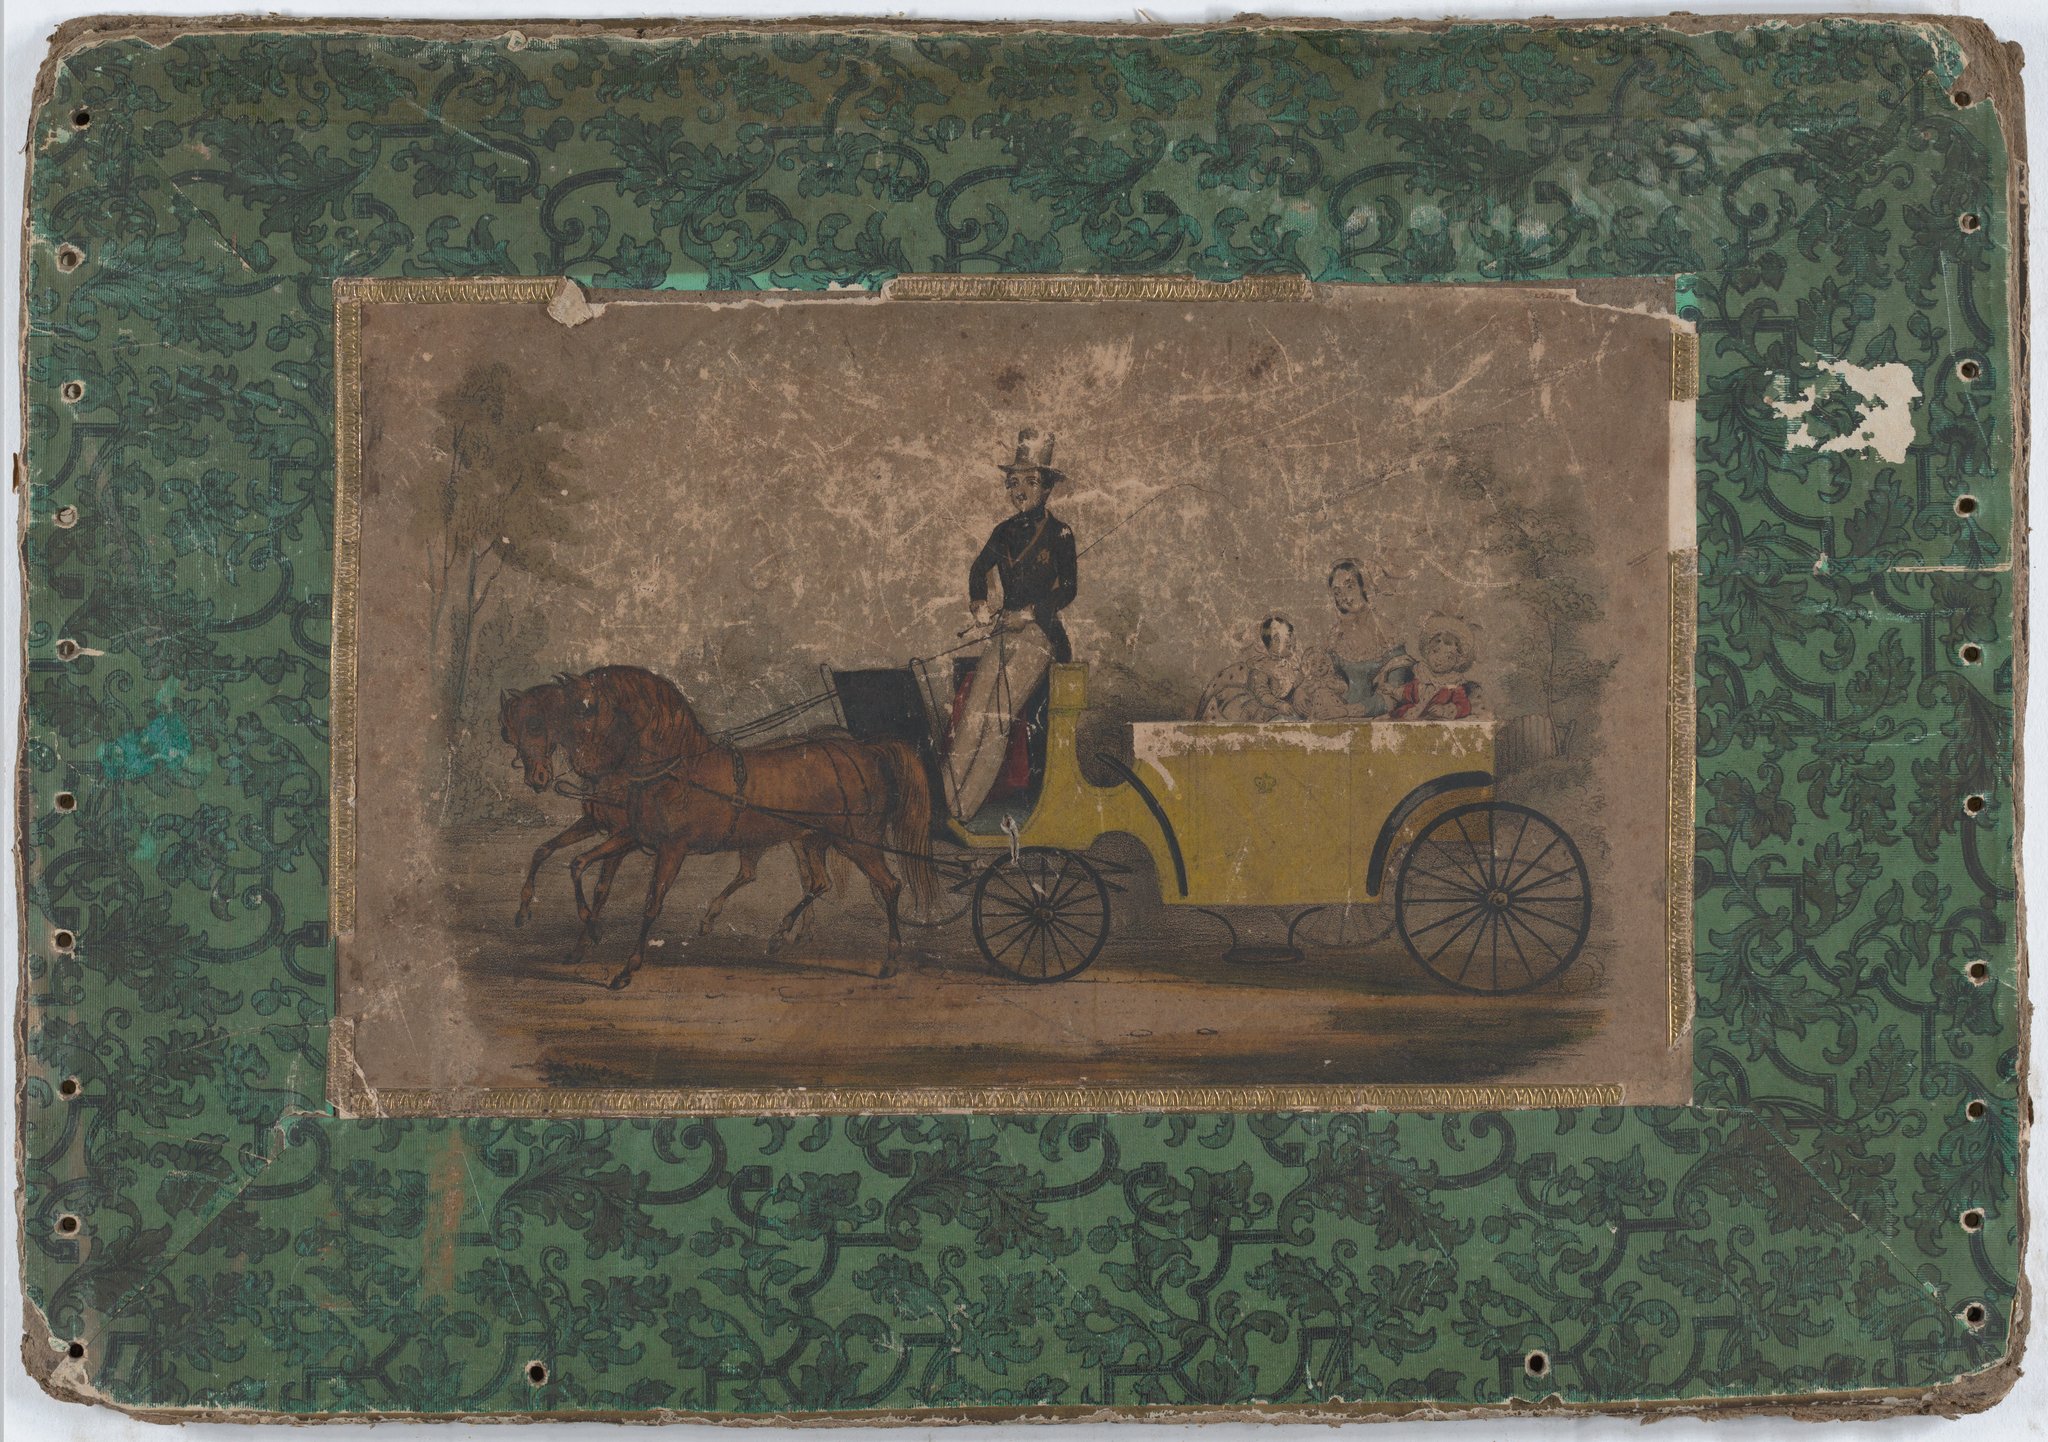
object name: portfolio cover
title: Portfolio Cover for a Collection of Caricatures and Satires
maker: anonymous, british, 19th century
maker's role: artist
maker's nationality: british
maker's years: 1800-1900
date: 1845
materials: board, paper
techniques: lithograph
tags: children,men,women,horses,carriages